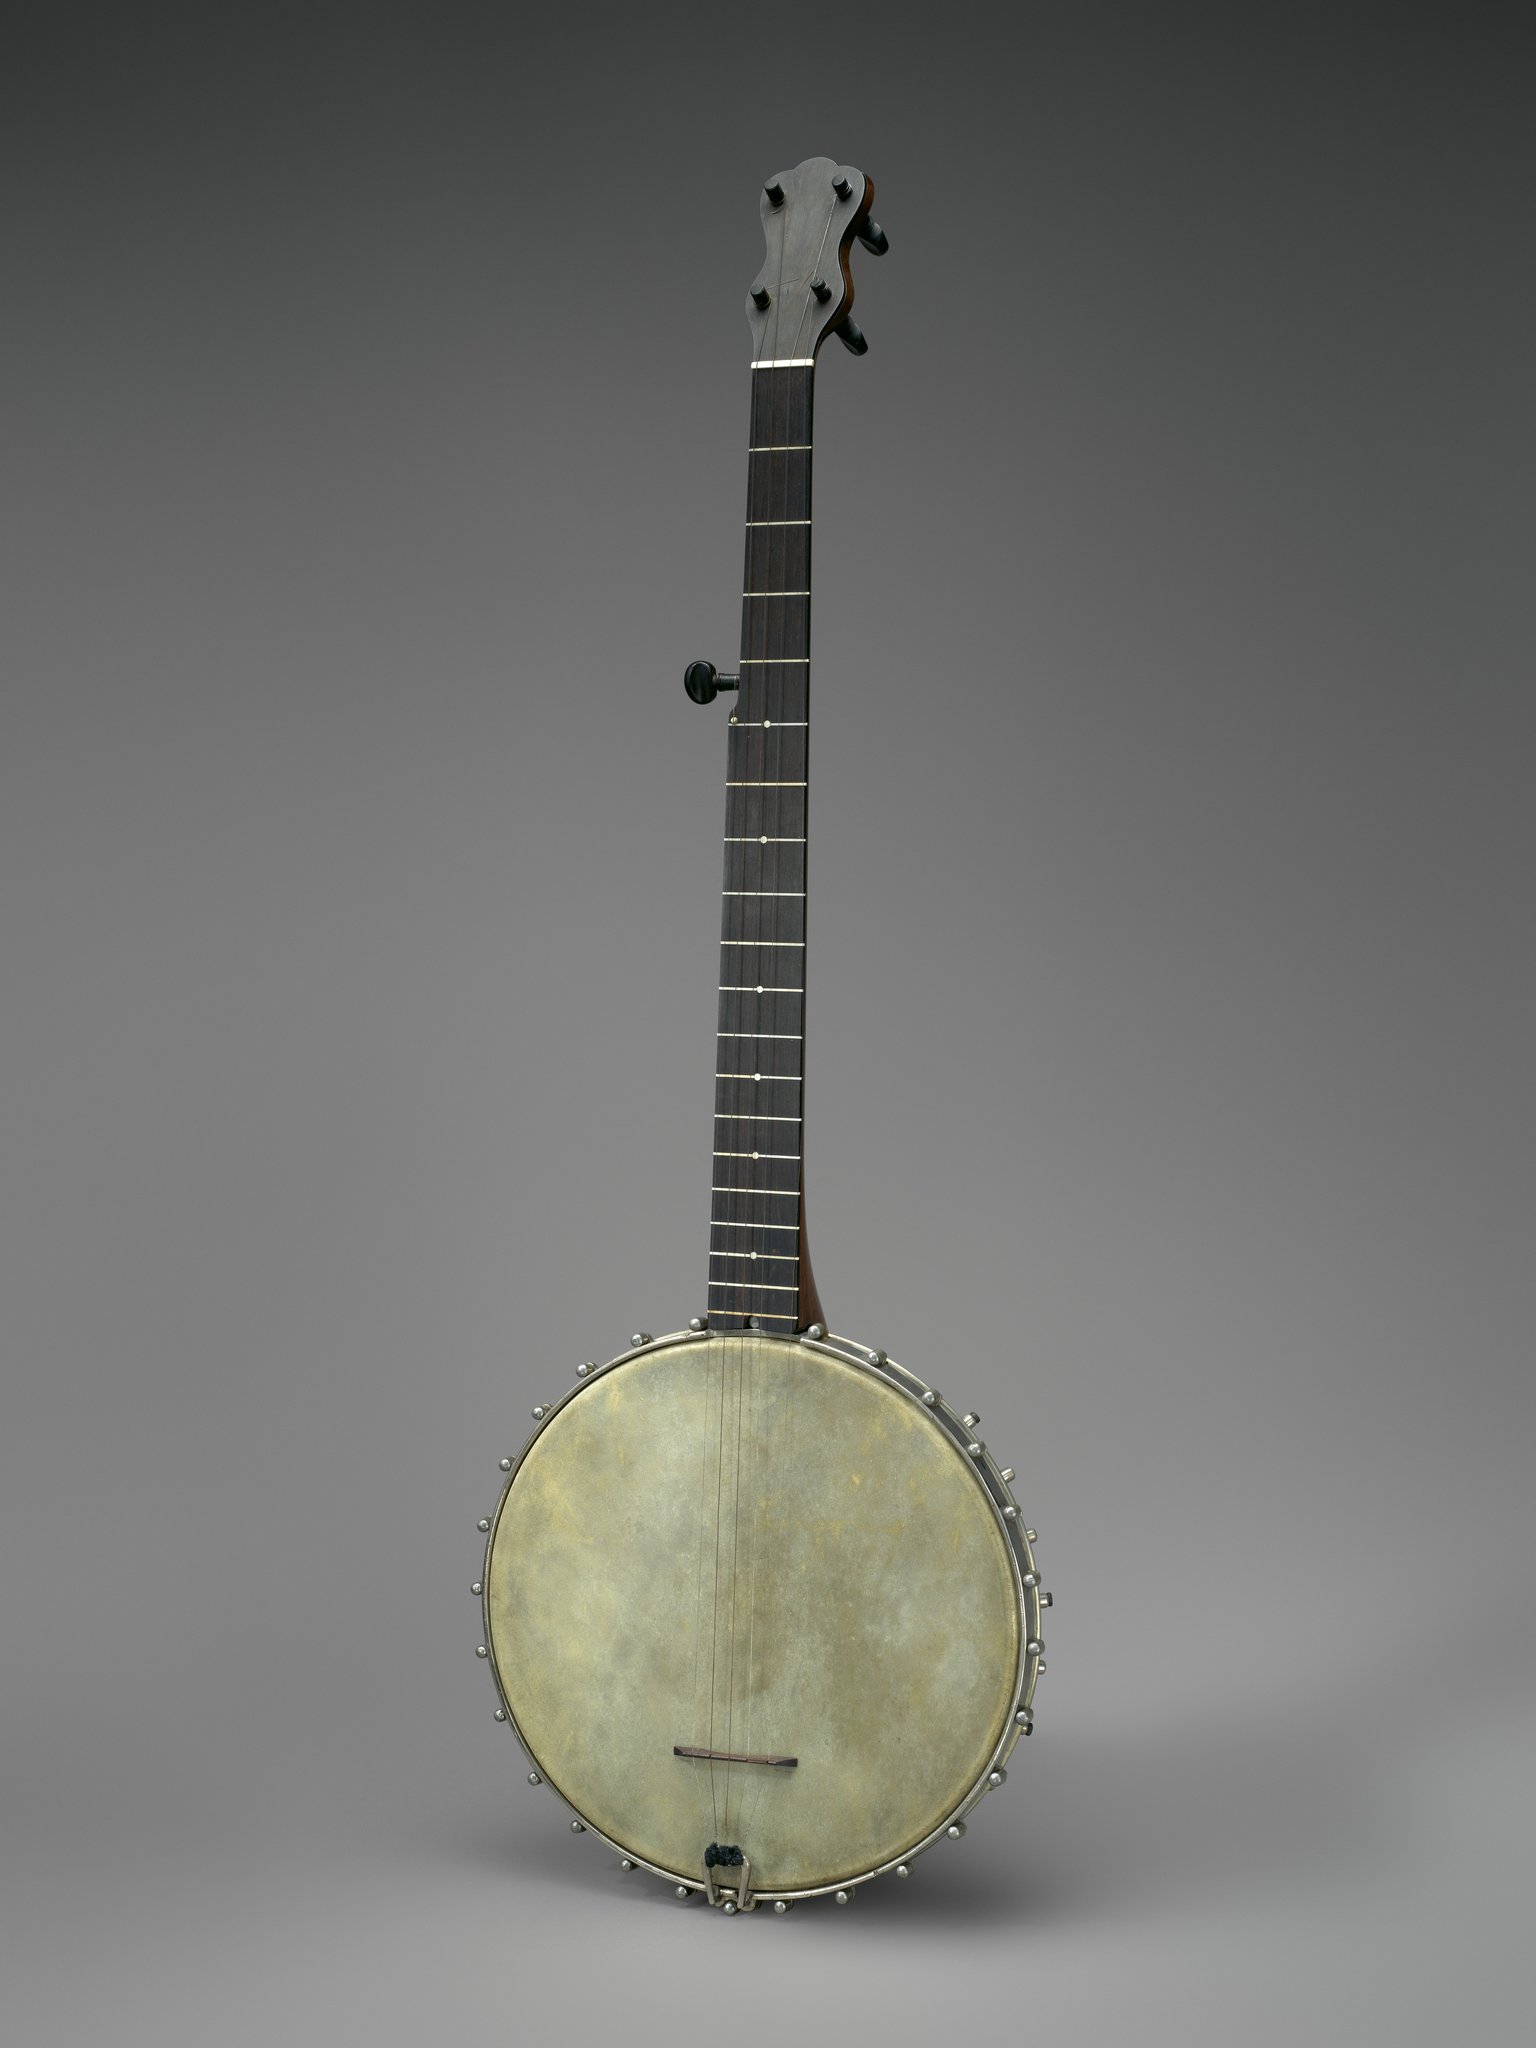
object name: banjo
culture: american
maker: hercules mccord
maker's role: maker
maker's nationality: american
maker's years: 1855-1890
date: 1884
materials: metal, parchment